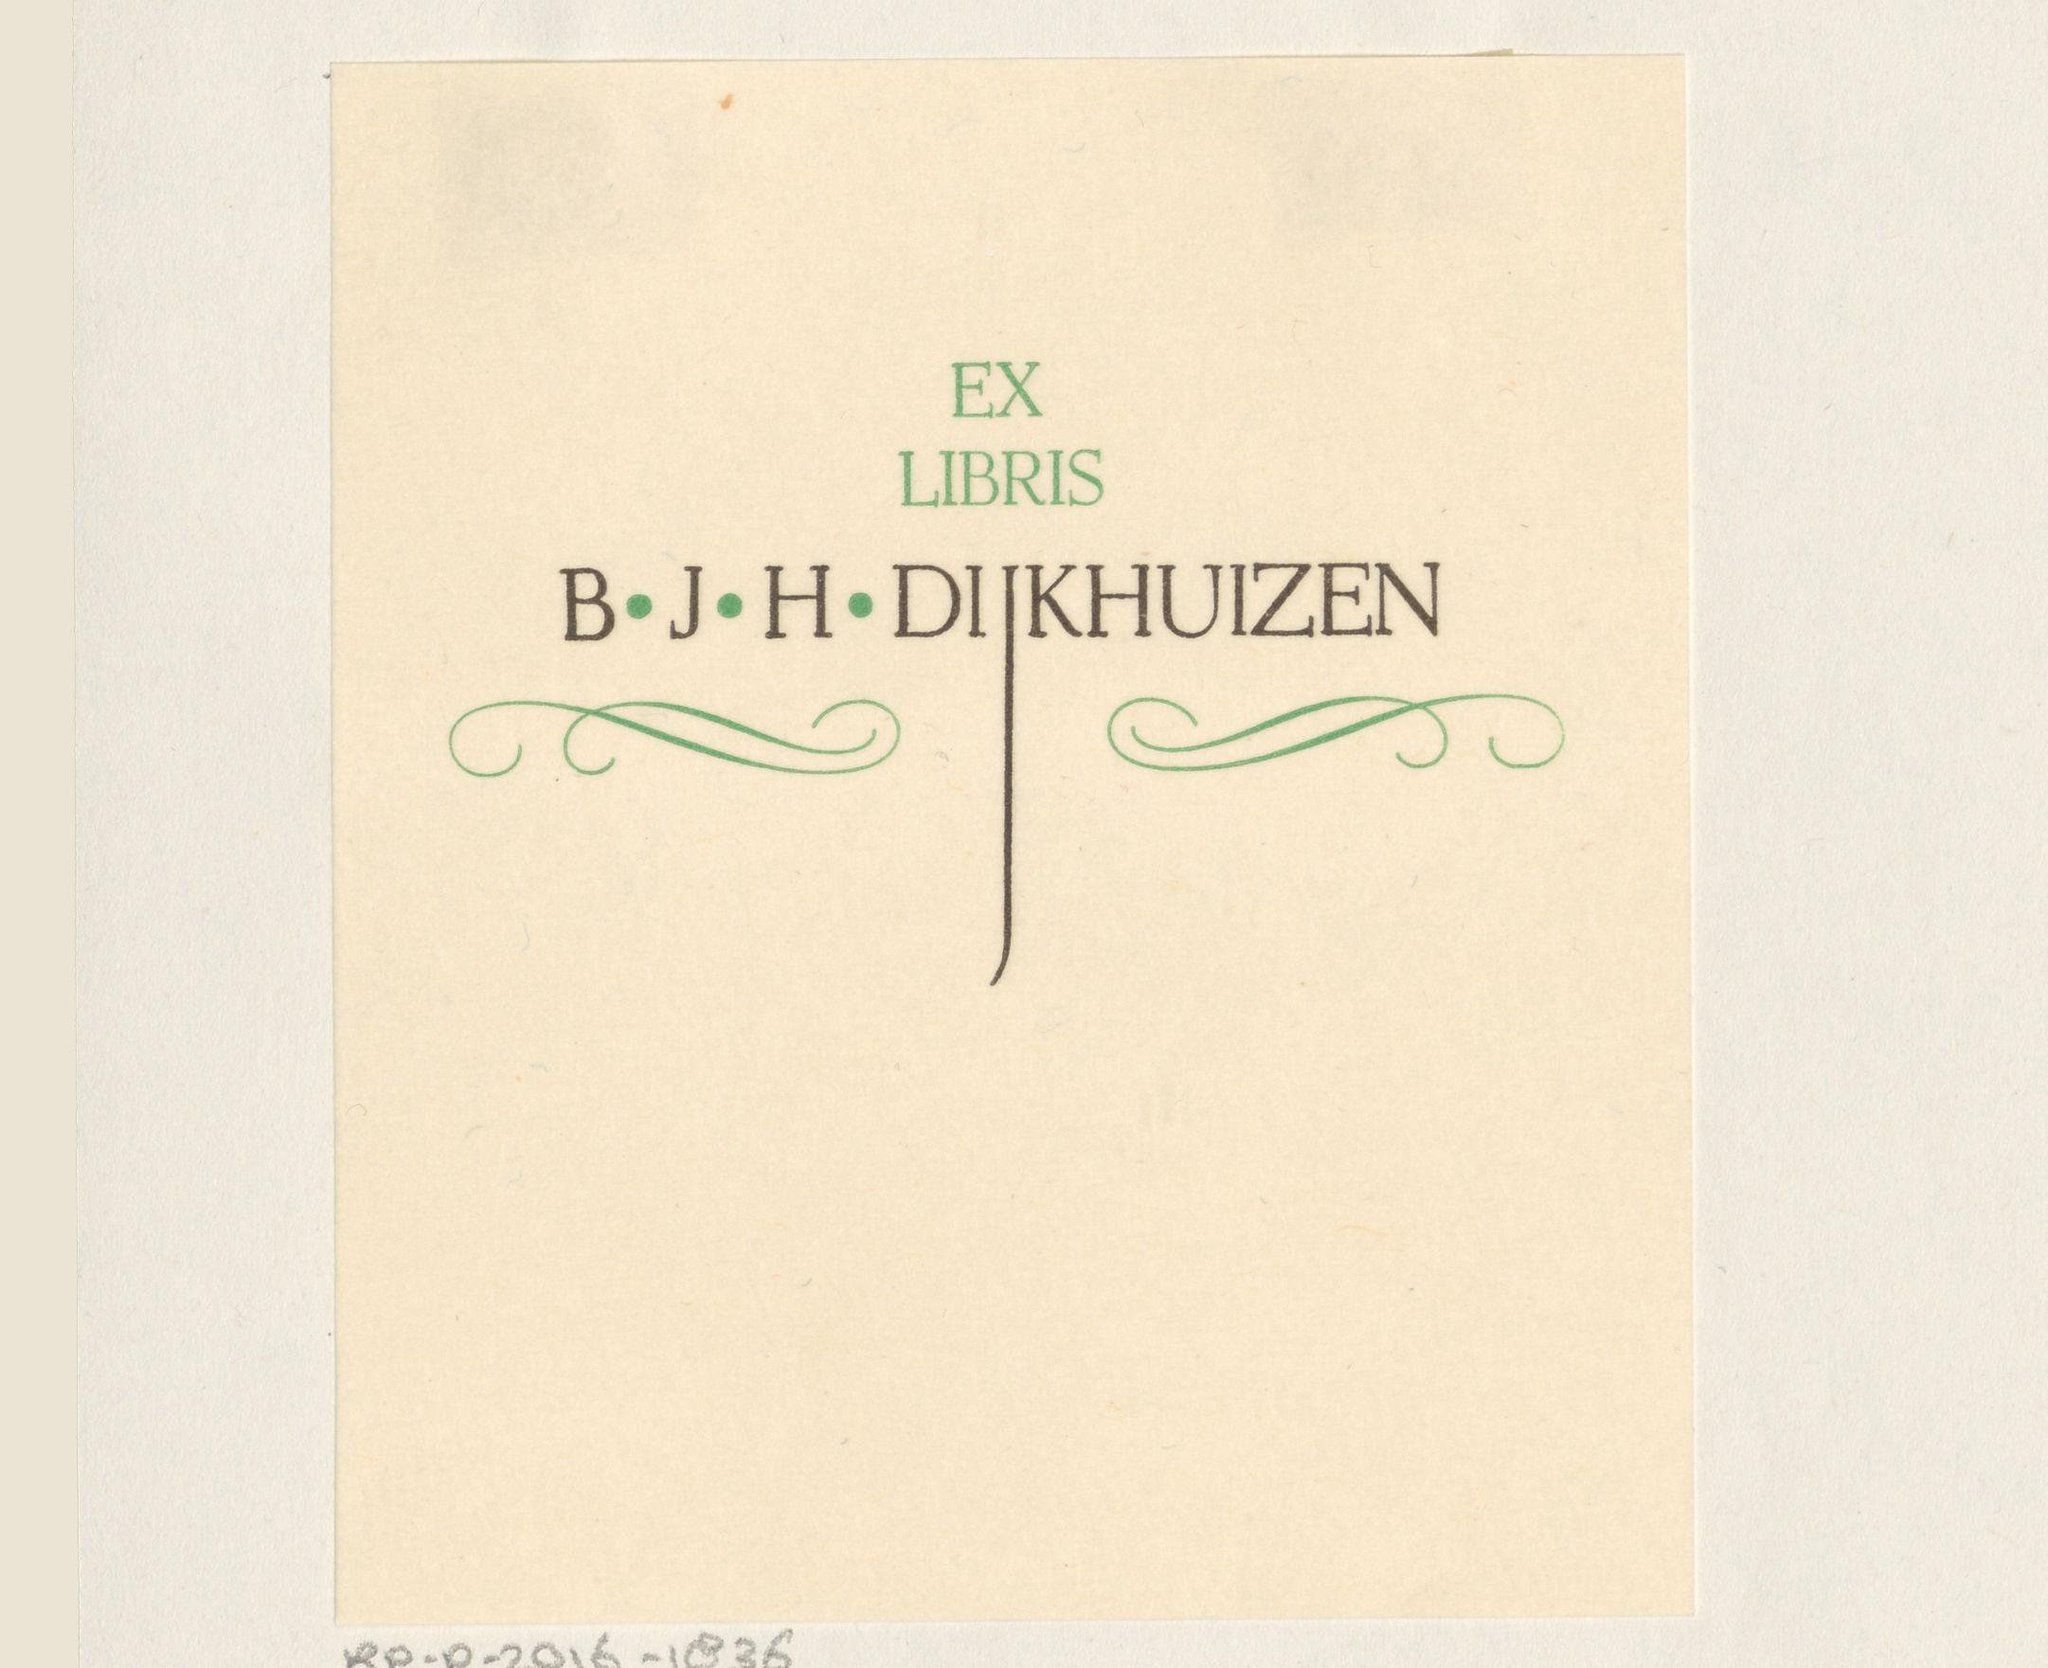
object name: bookplate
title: Ex libris van B.J.H. Dijkhuizen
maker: b. timmer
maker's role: print maker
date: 1940-1960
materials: paper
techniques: printing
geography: netherlands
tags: b.j.h. dijkhuizen